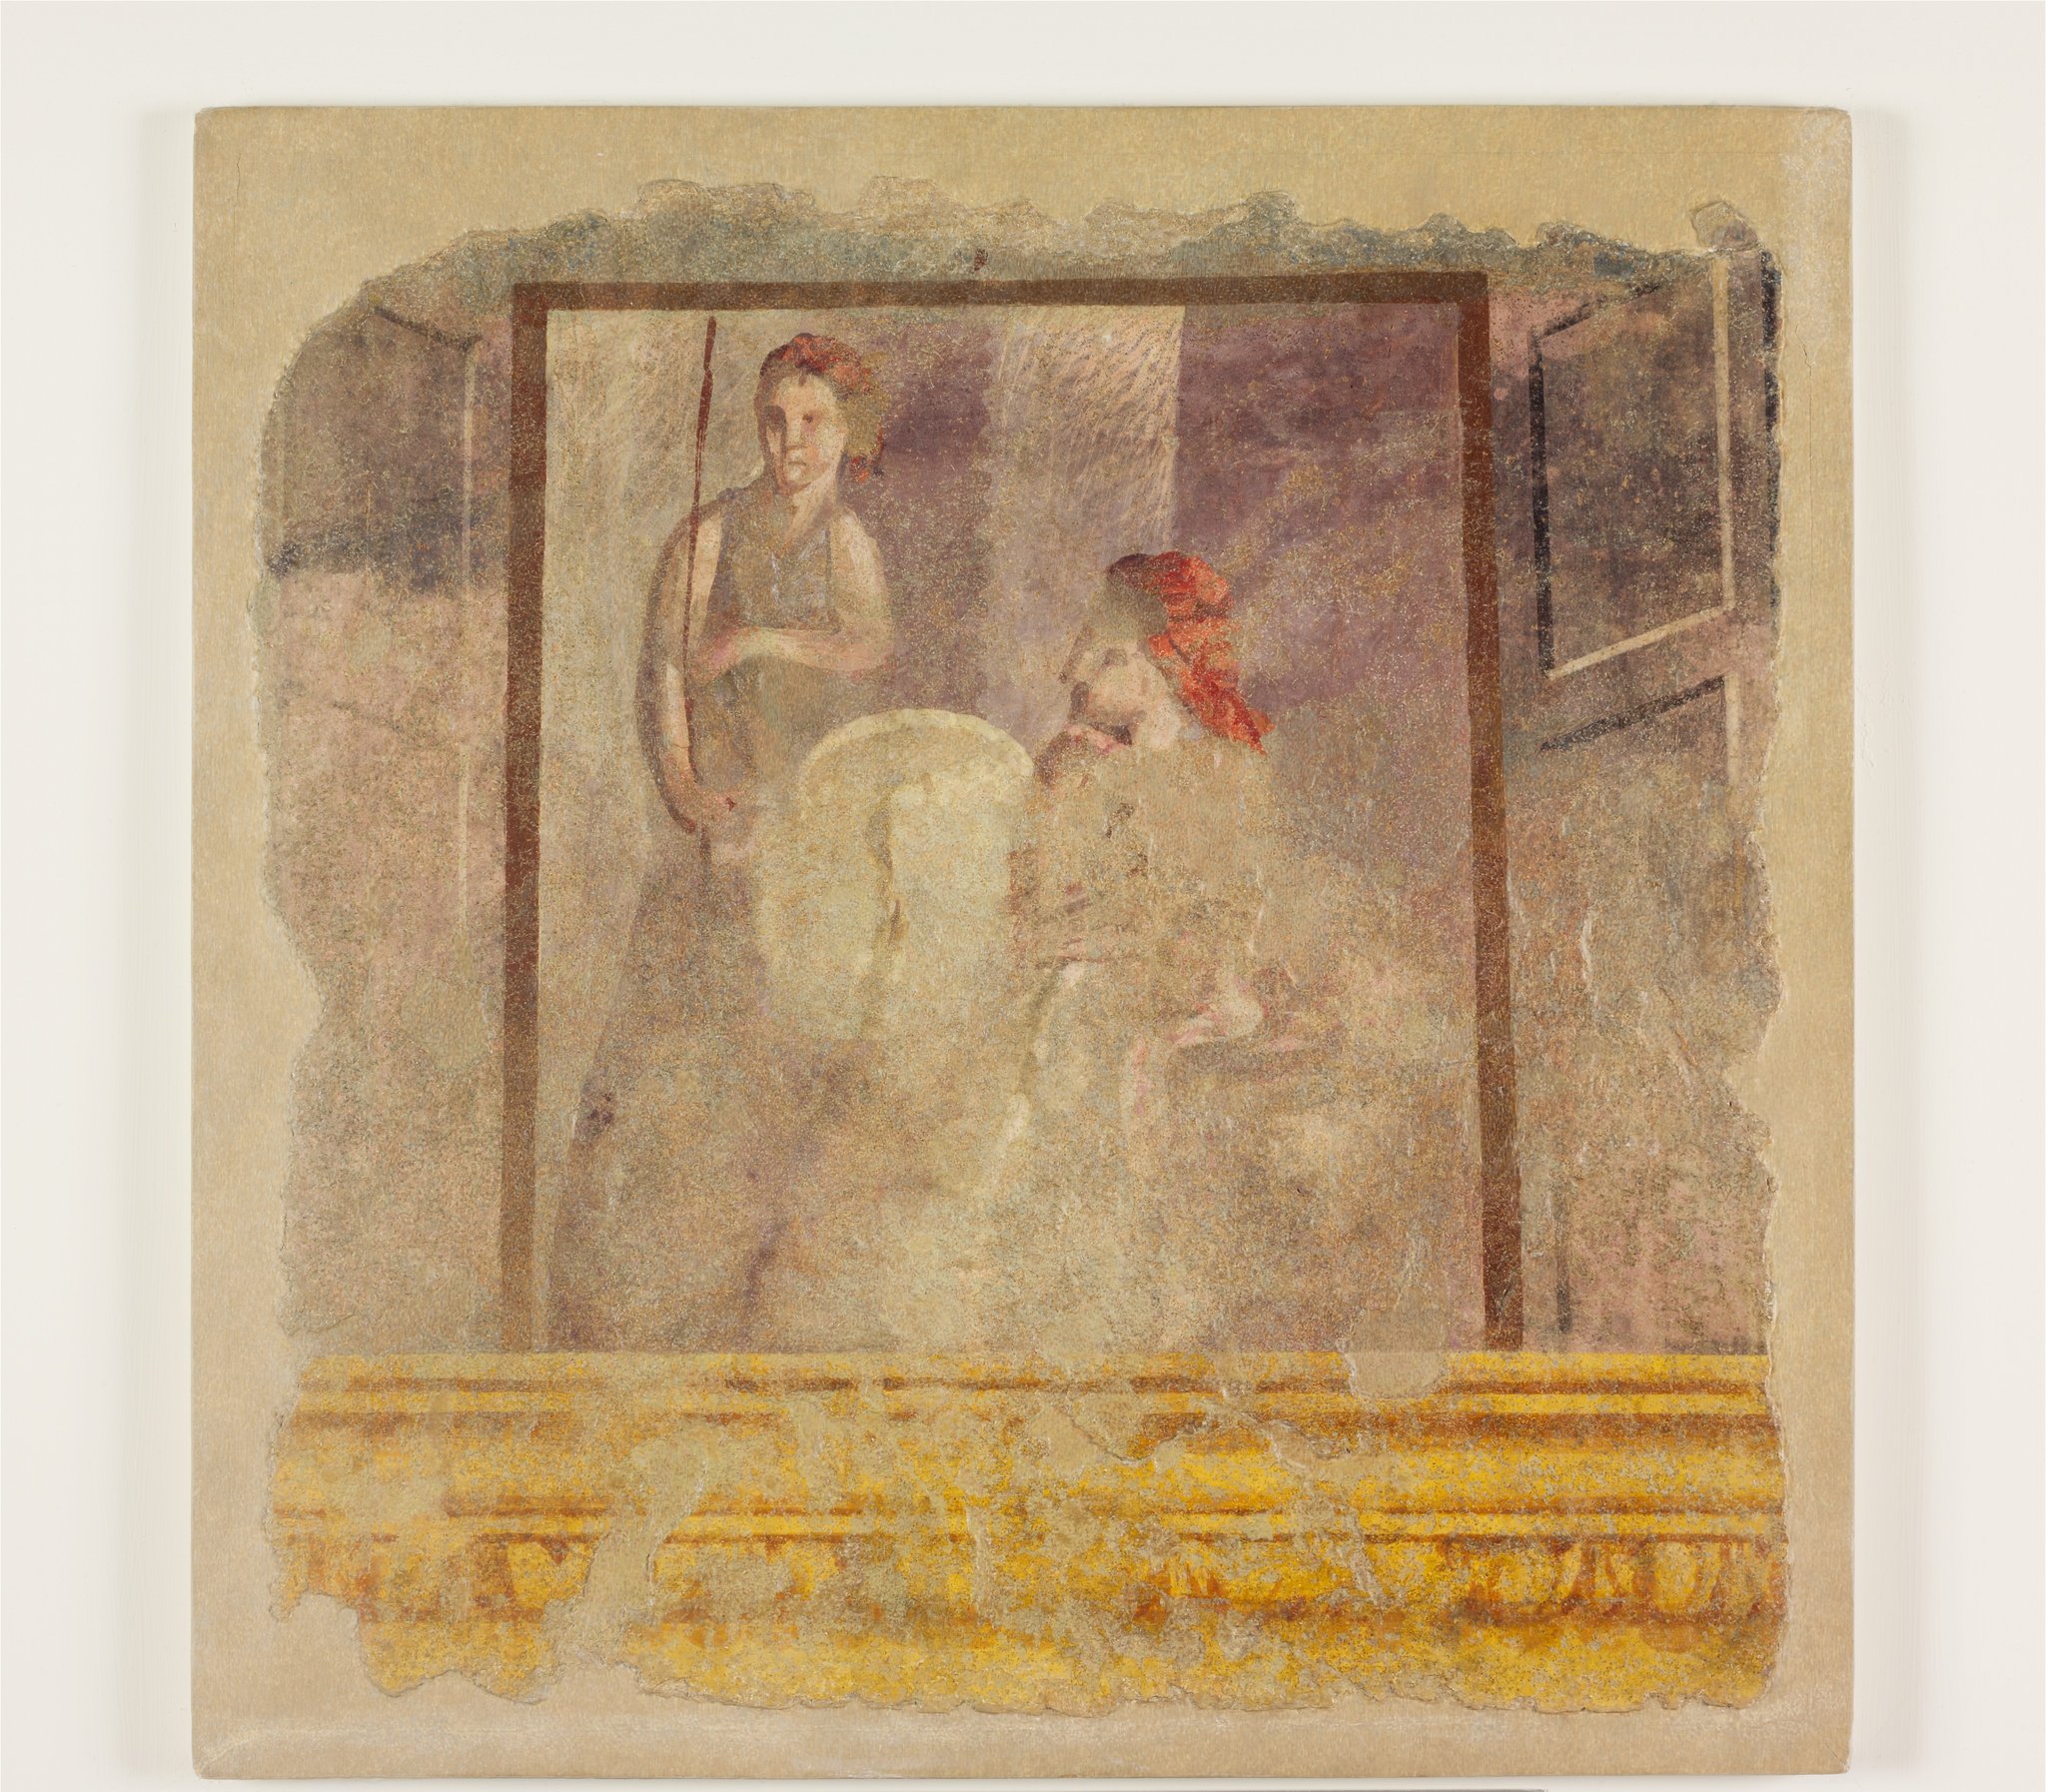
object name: wall painting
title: Wall painting fragment from the north wall of Room H of the Villa of P. Fannius Synistor at Boscoreale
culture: roman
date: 50-40 BCE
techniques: fresco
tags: shields,women